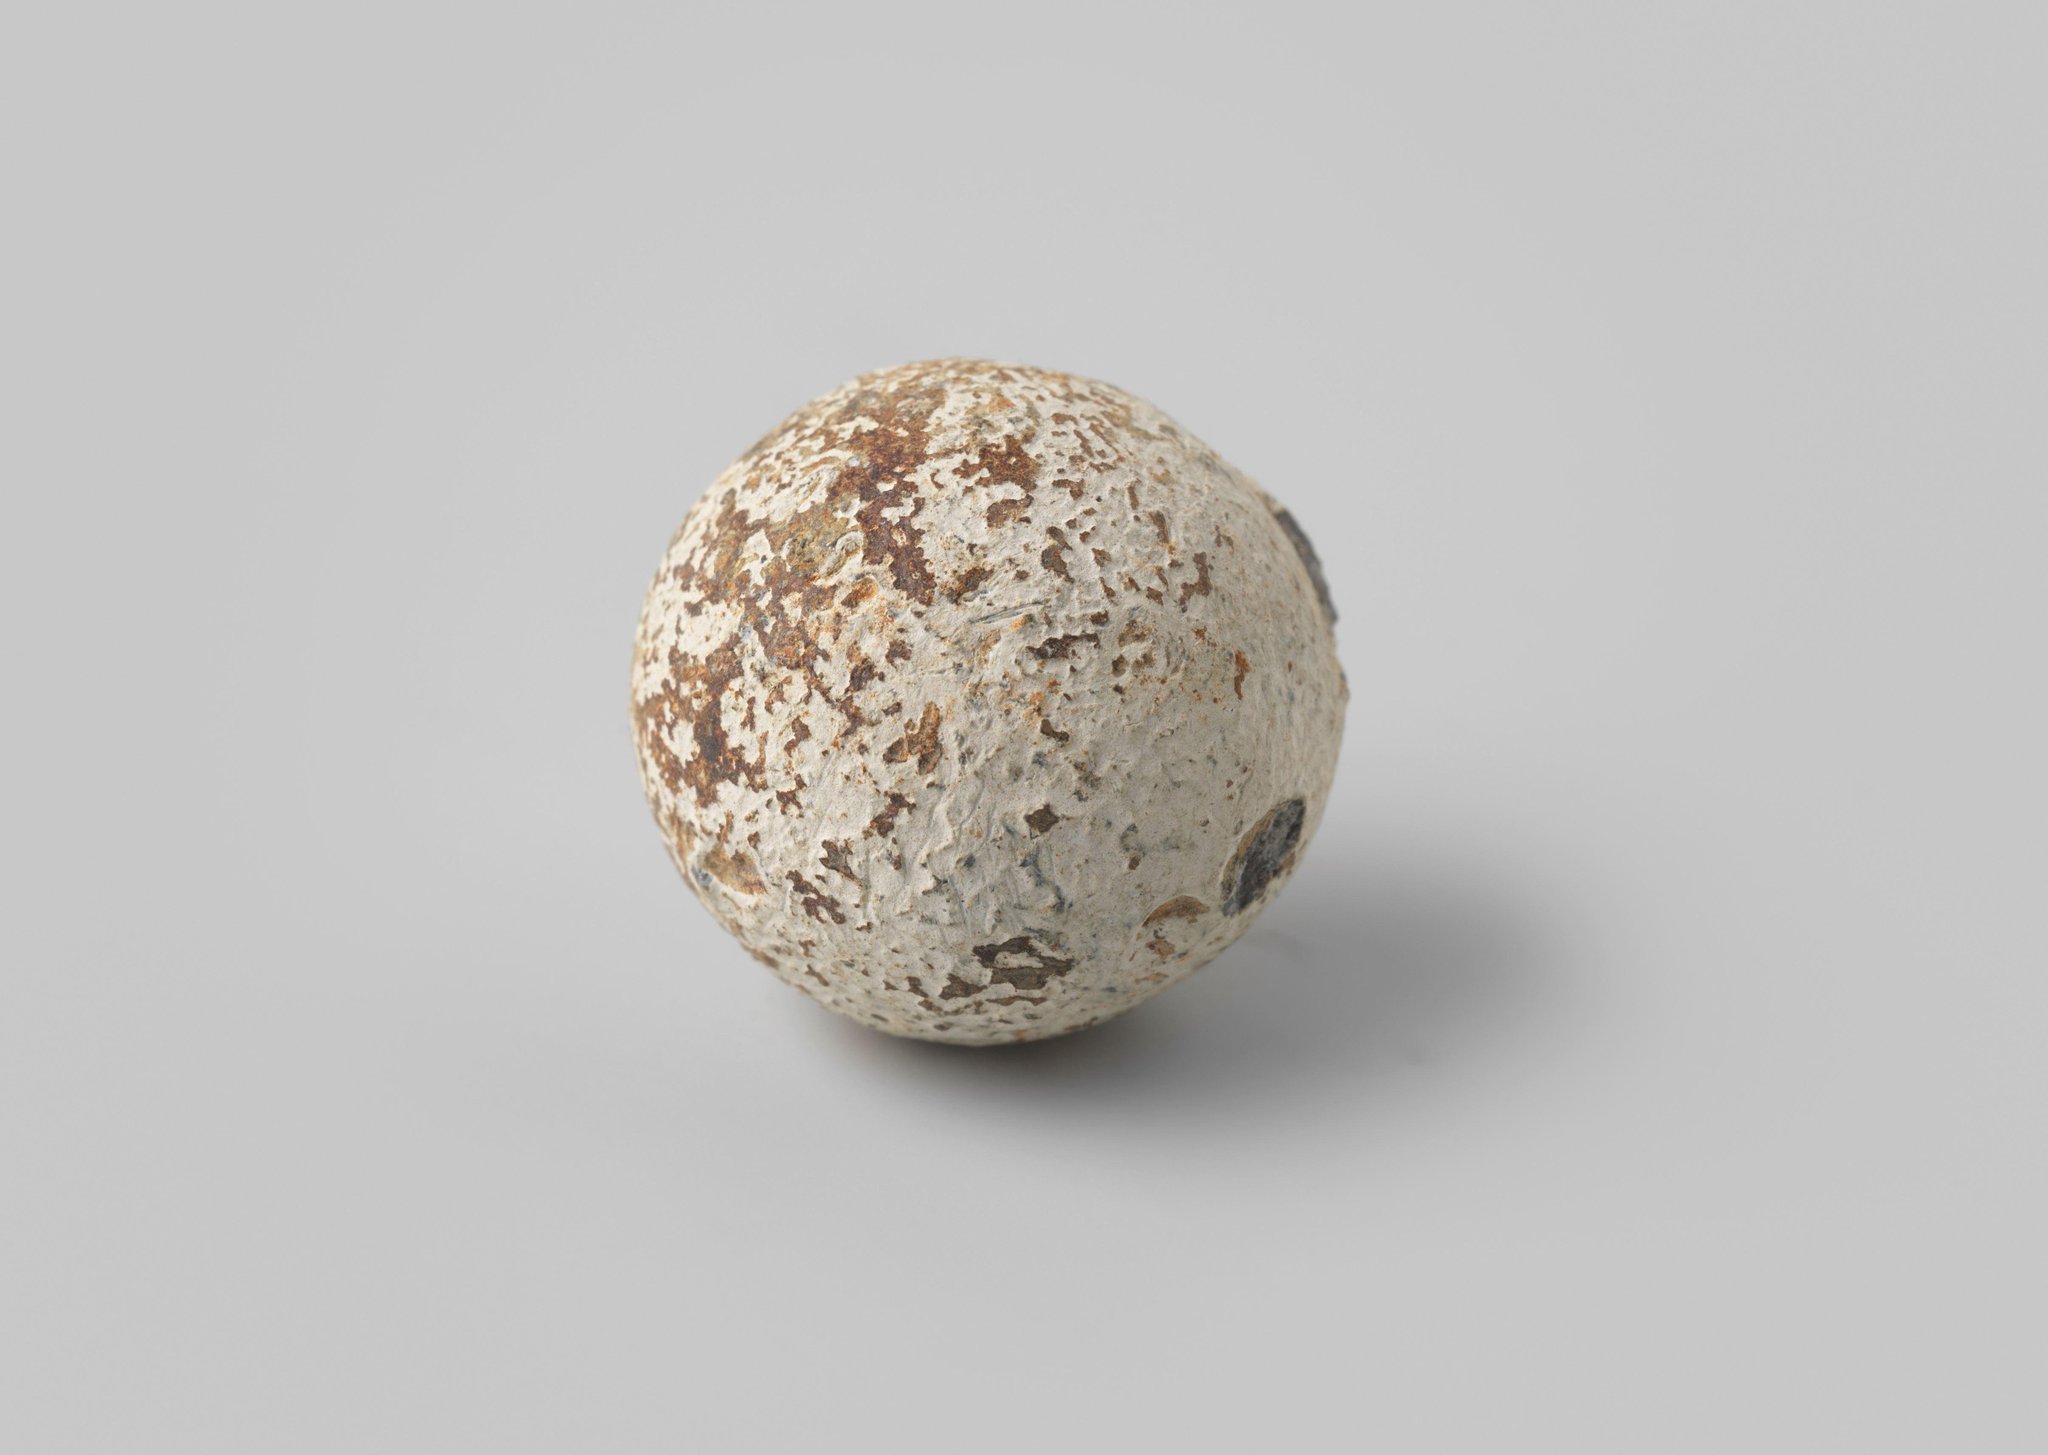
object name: musketkogel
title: Musketkogel uit het wrak van de Oost-Indiëvaarder Hollandia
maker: Anonymous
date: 1700-1743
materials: lead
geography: netherlands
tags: verenigde oostindische compagnie, hollandia (schip), annet